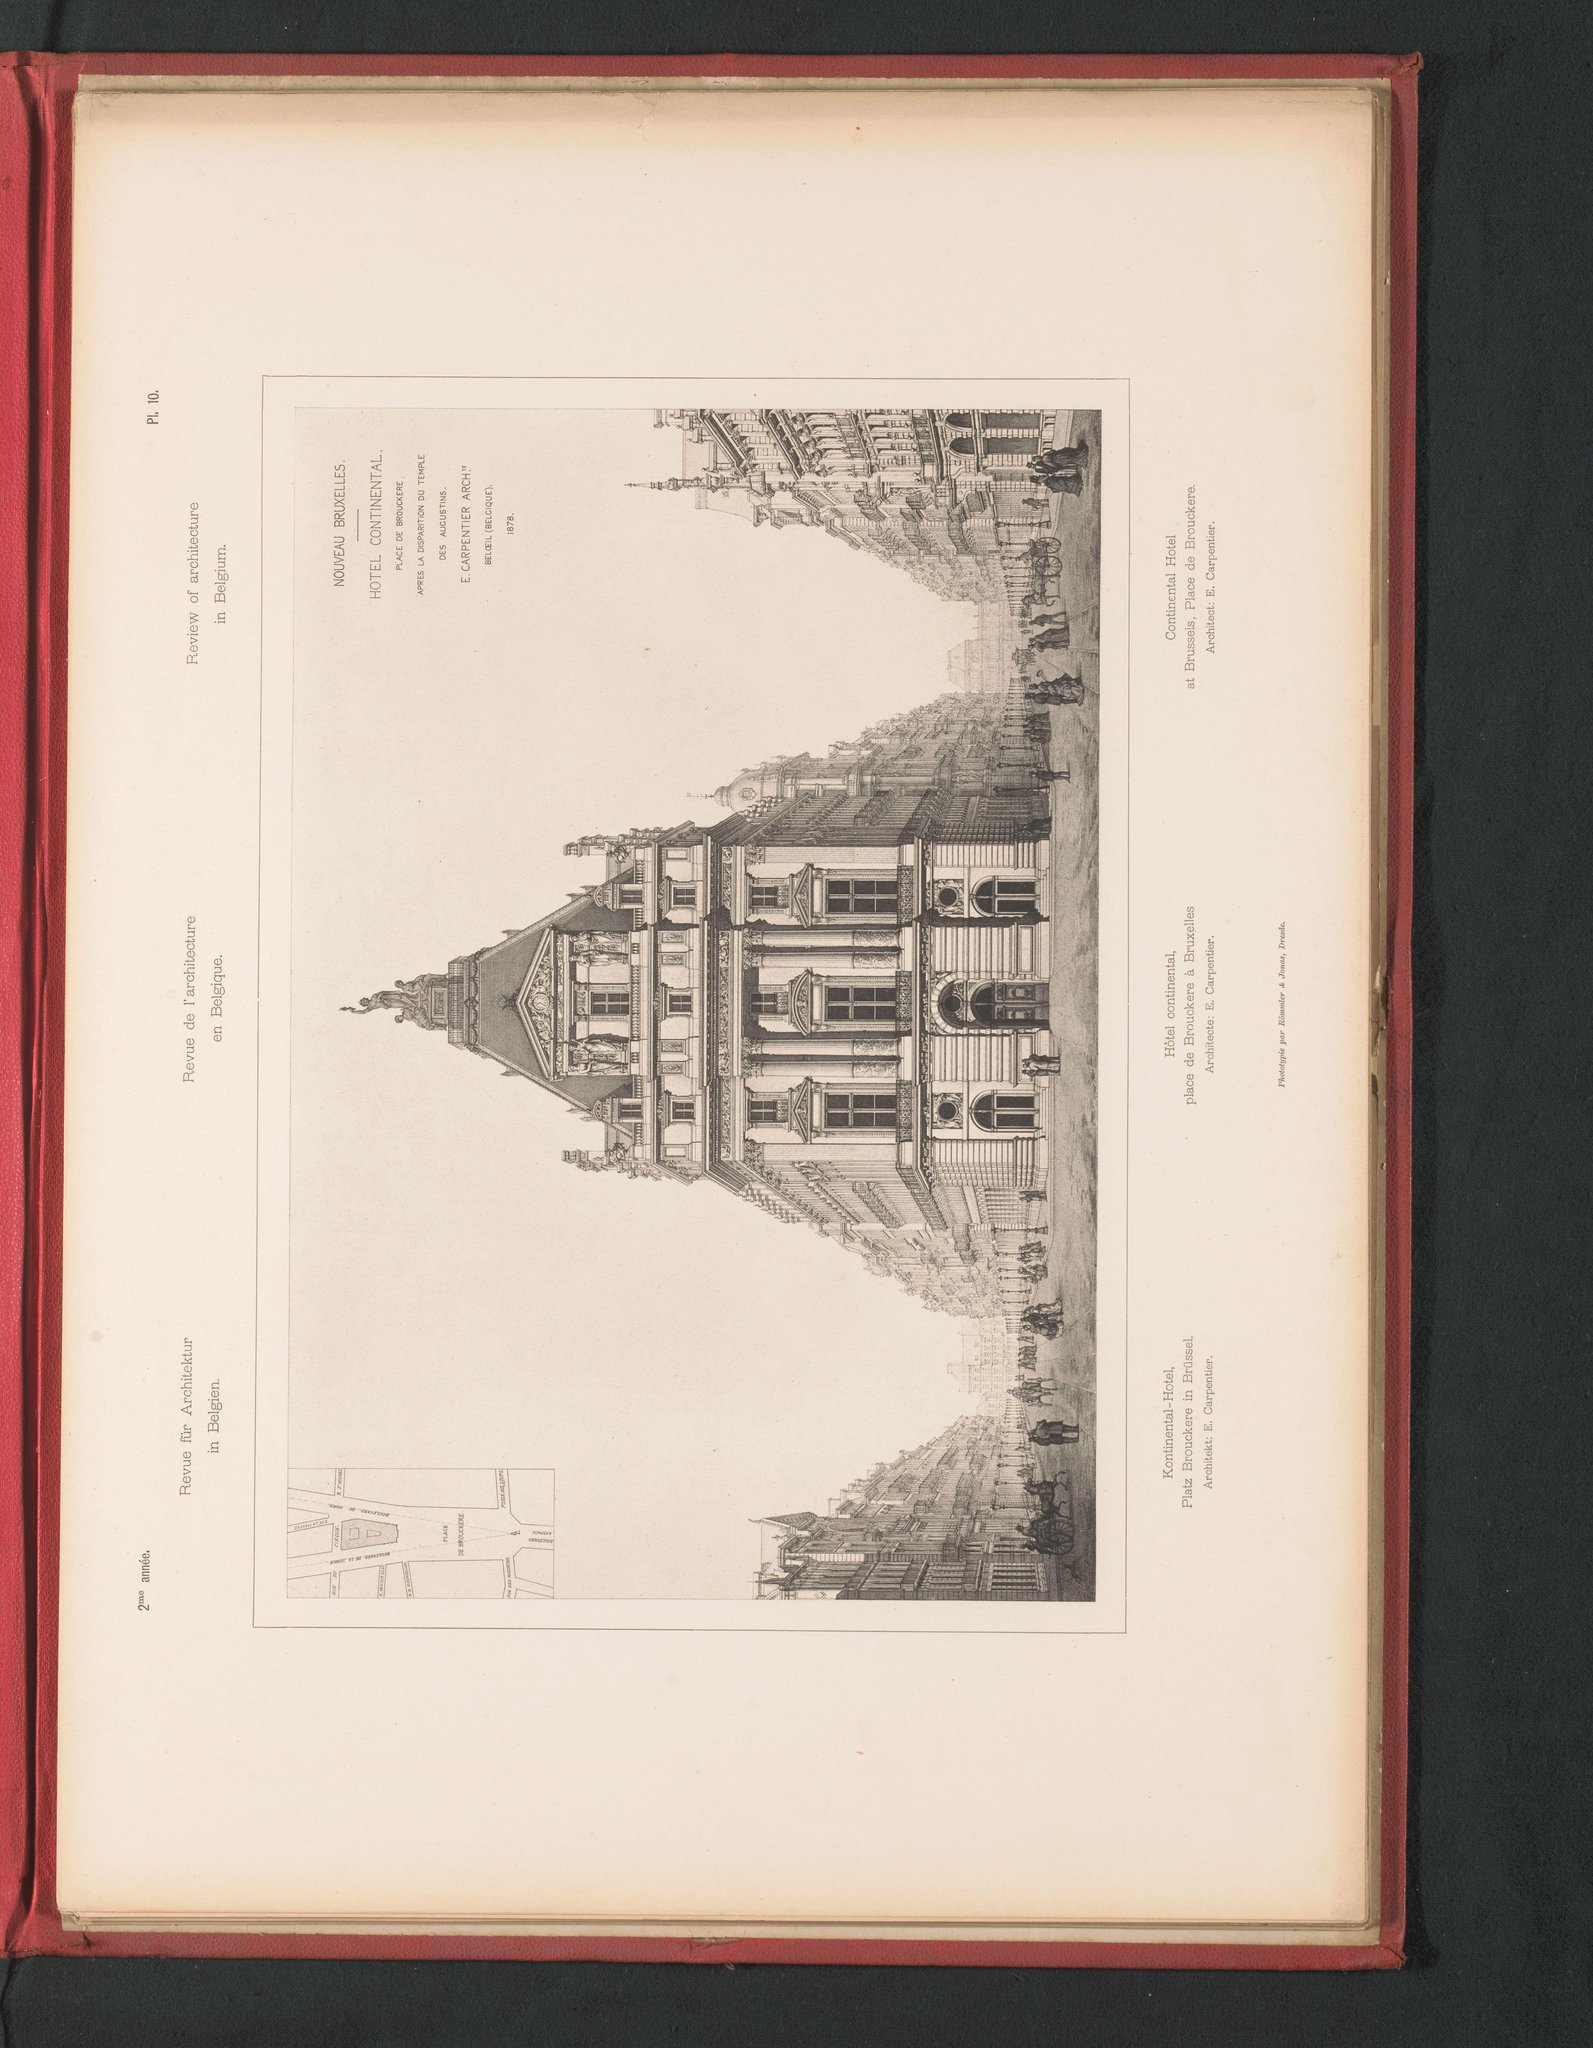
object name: reproduction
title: Revue für Architektur in Belgien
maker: eugène carpentier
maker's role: architect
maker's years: 1819-1886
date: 1888-1893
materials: paper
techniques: photograph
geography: dresden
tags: exterior ~ architectural design or model, hotel, hostelry, inn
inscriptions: inscription: ‘2me. année.’, number: ‘Pl. 10.’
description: Deze prent maakt deel uit van een omslag met 110 prenten op 90 bladen en 18 tekstbladen.